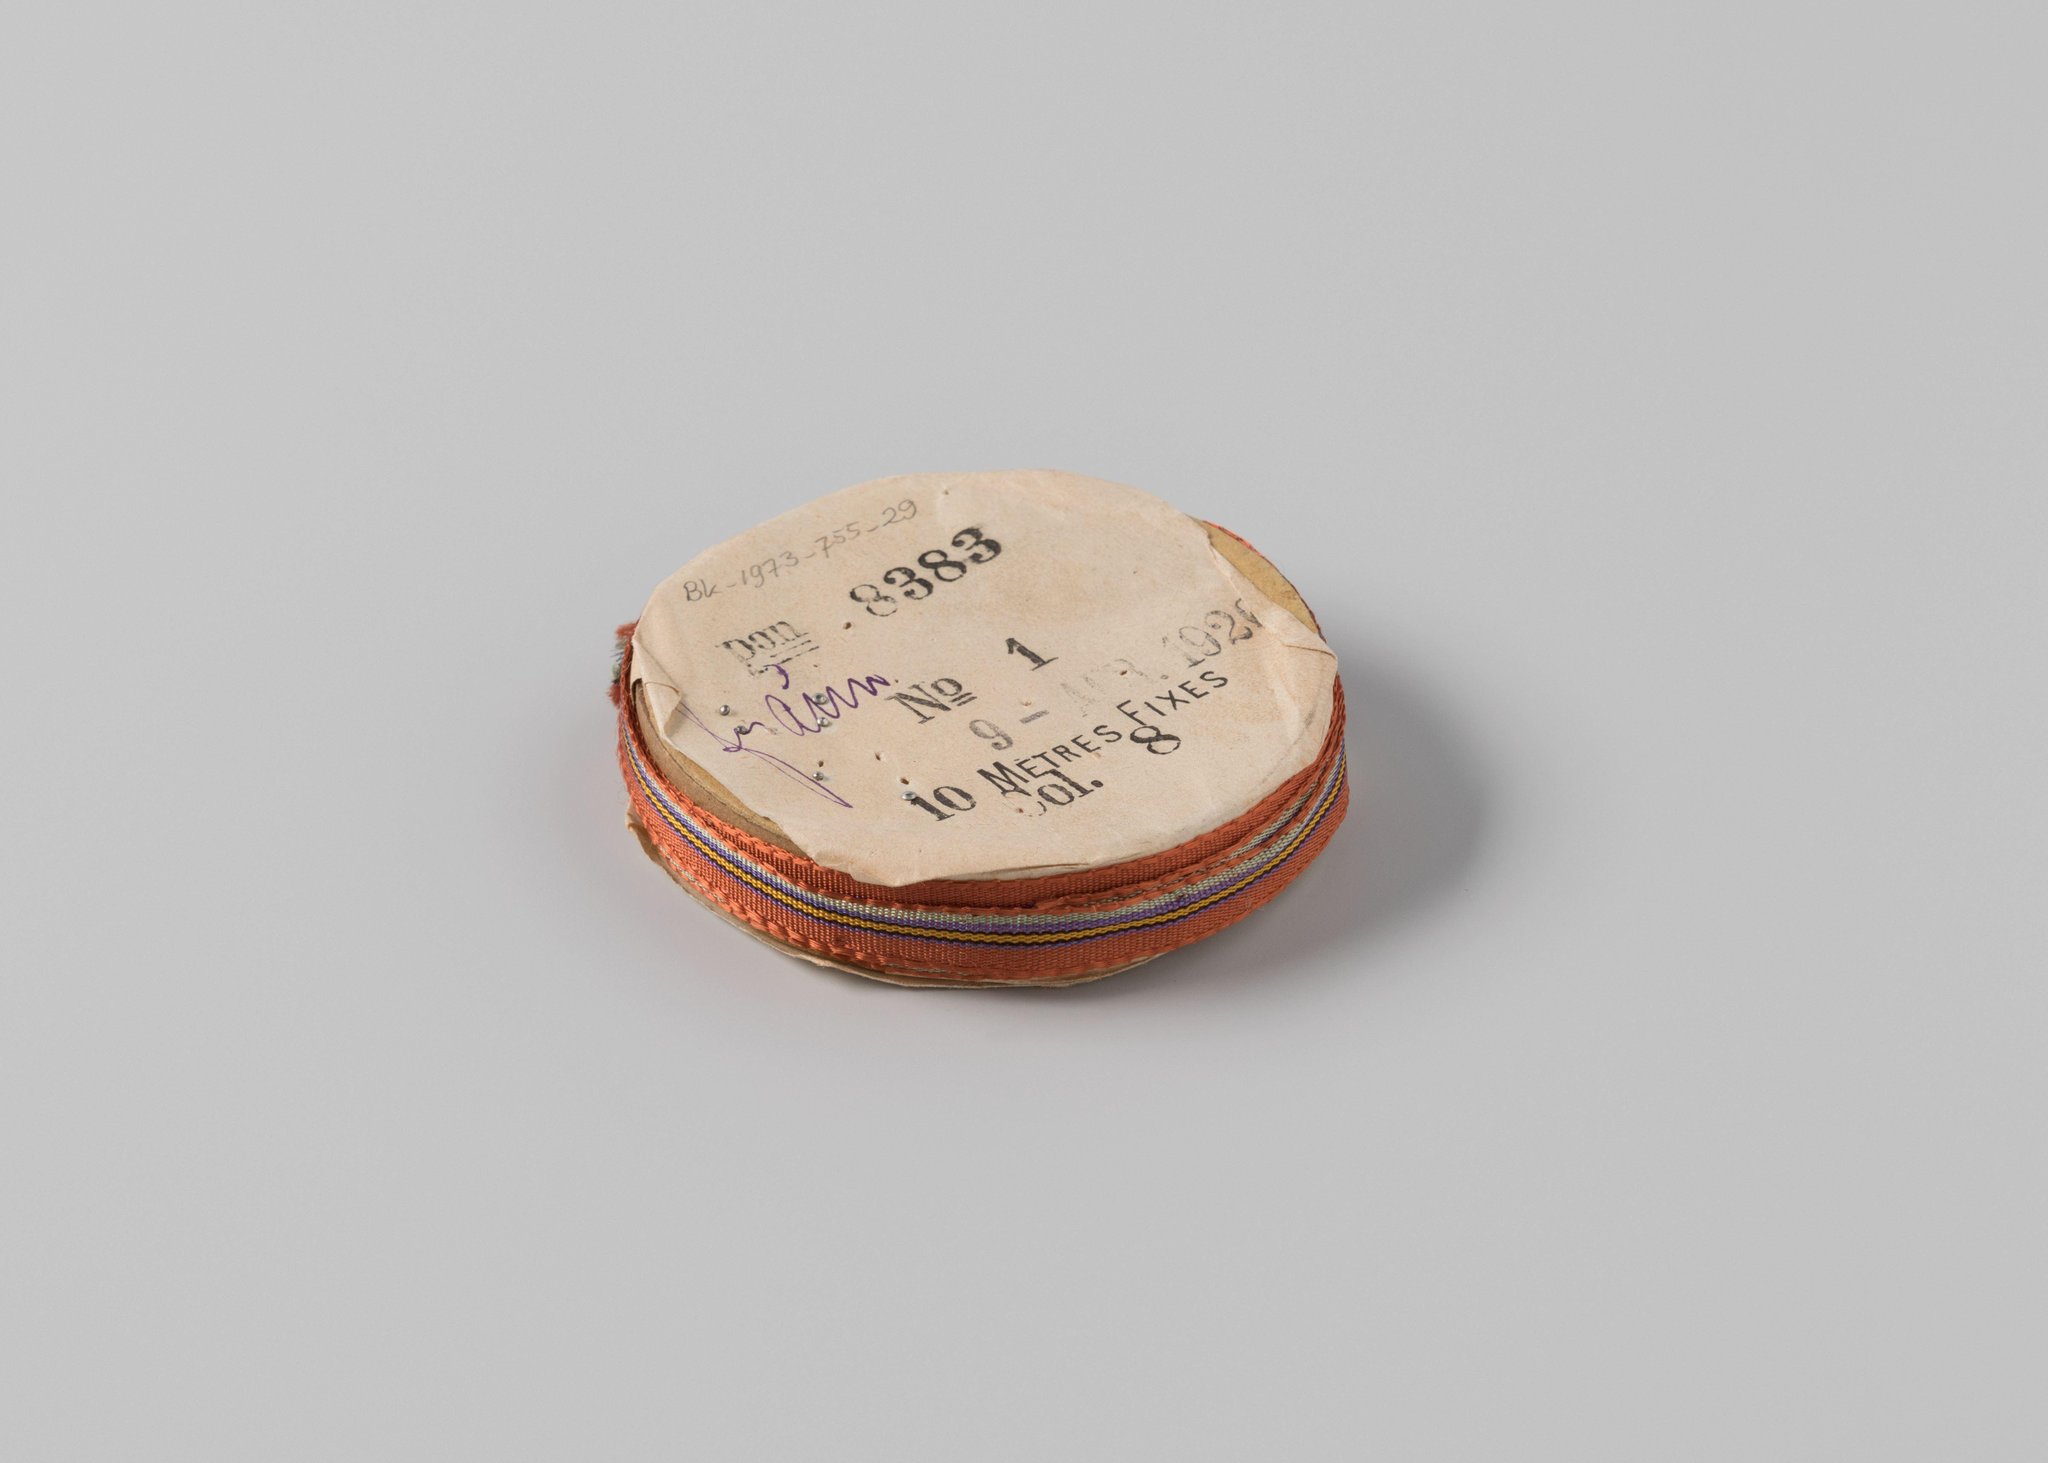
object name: ribbon material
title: Lint op rol, gestreept, roodbruin met lila, zwart, lichtgroen en oranje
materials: cardboard, paper, textile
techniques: weave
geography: france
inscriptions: stamp: ‘9 - APR. 1926’, number: ‘Pon 8383’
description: Lint op rol, gestreept, roodbruin met lila, zwart, lichtgroen en oranje.